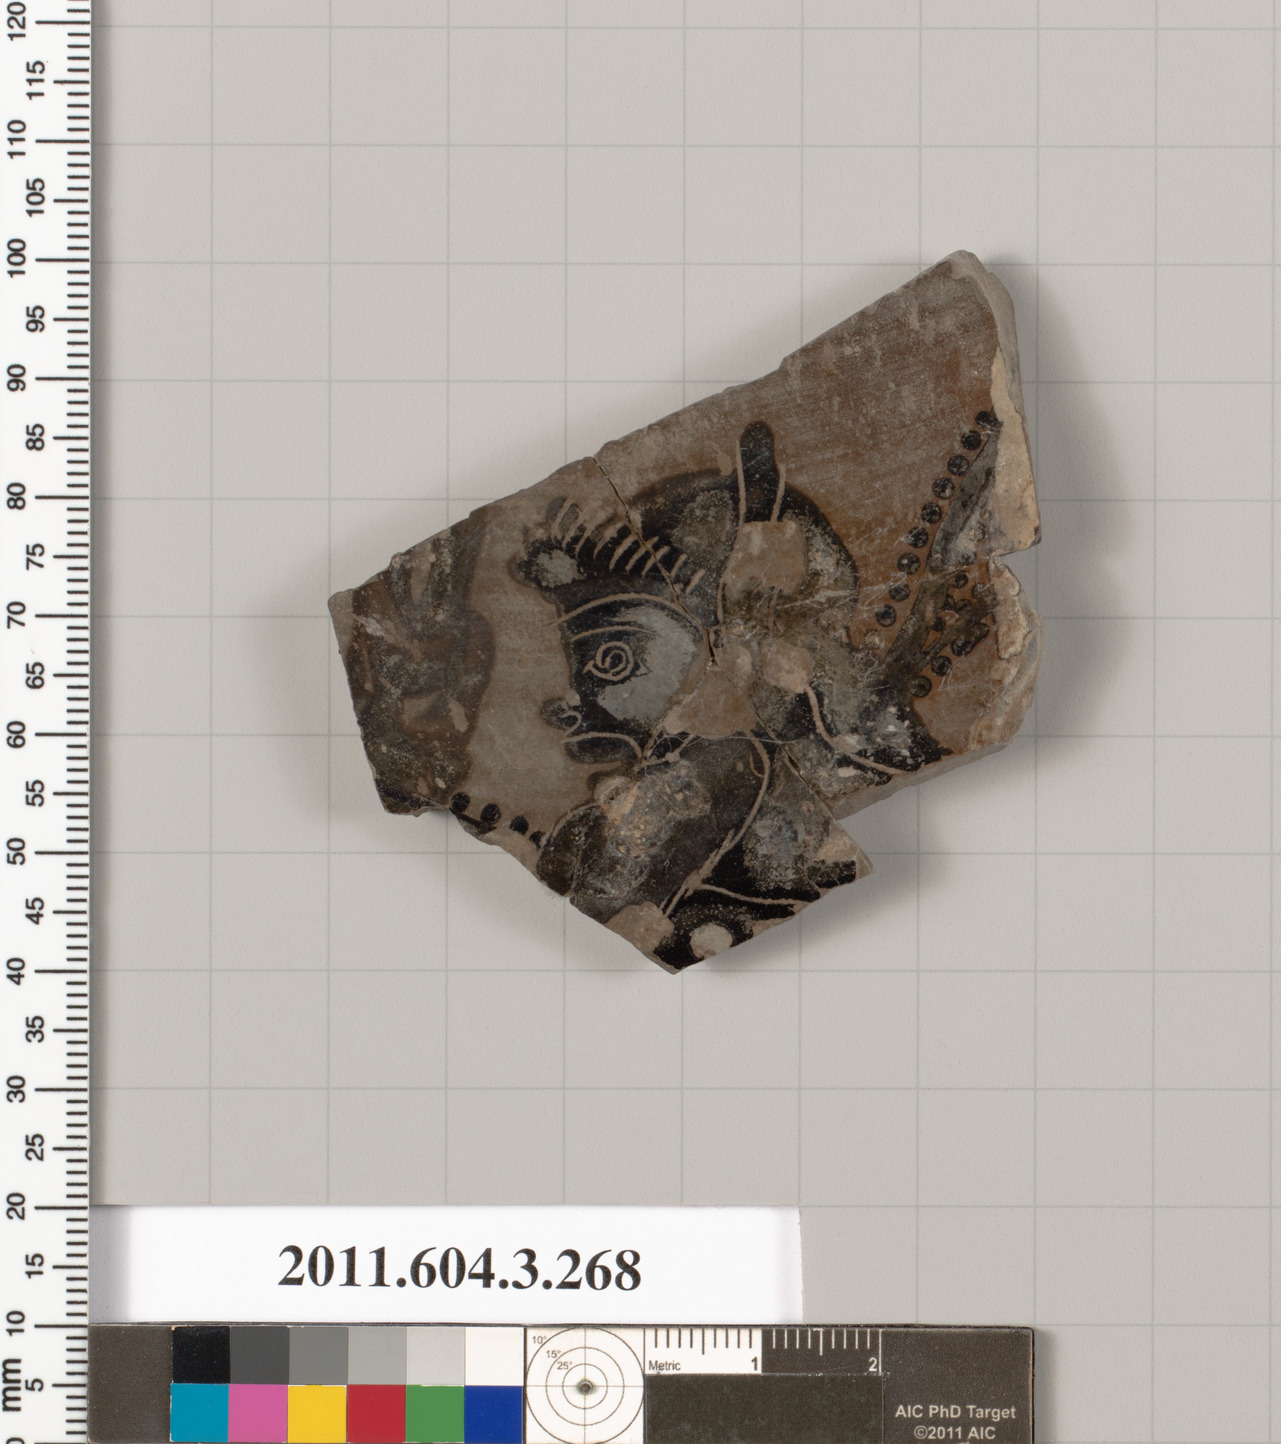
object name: neck amphora fragment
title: Terracotta fragment of a neck-amphora (jar)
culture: greek, attic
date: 534-468 BCE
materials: terracotta